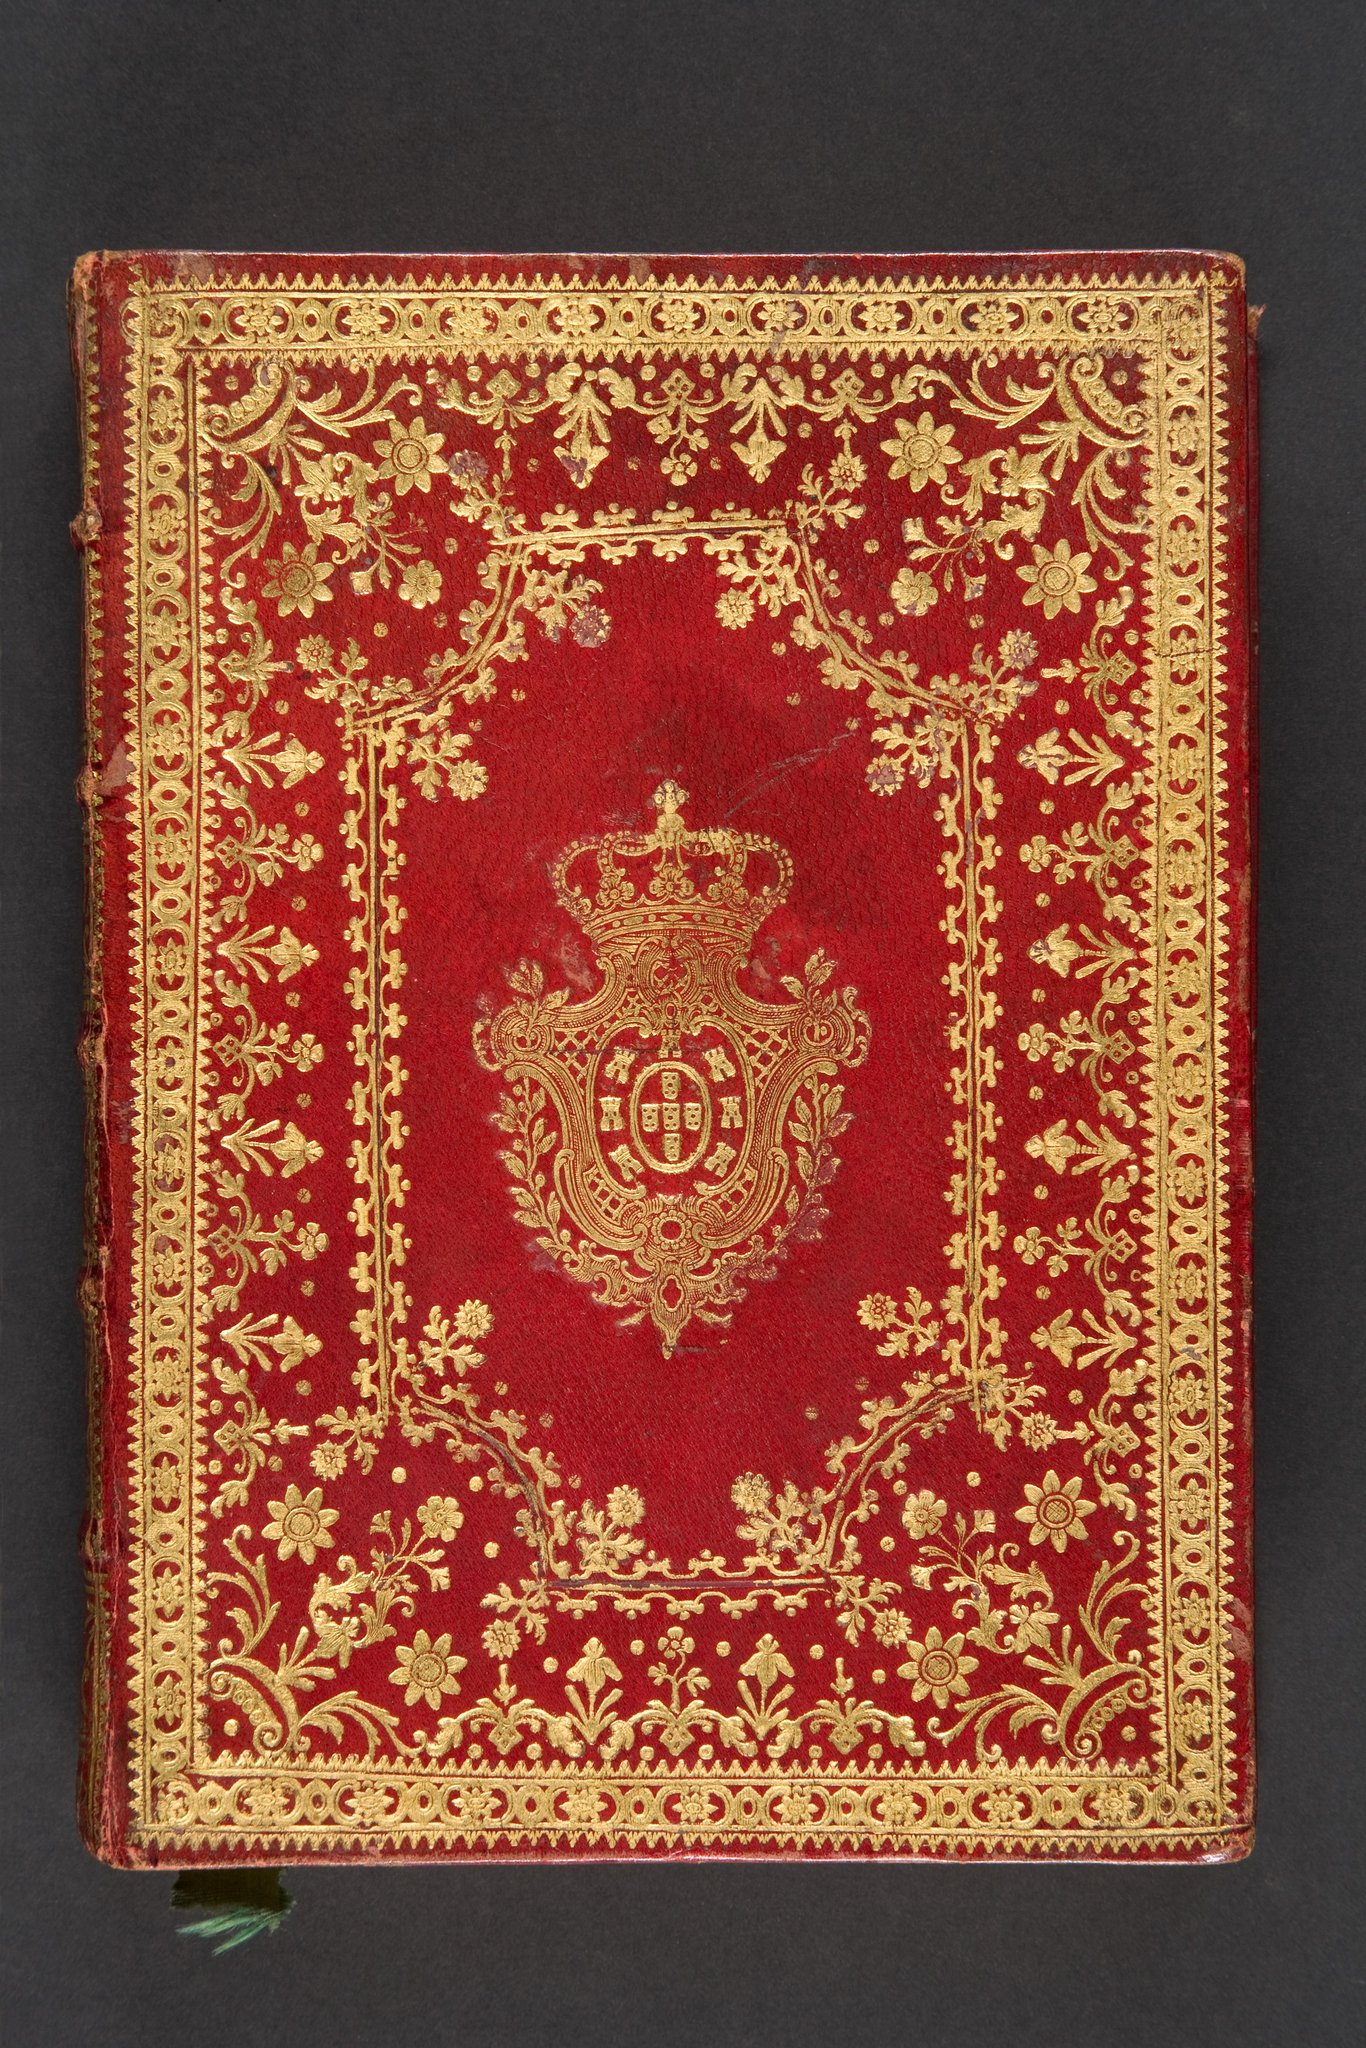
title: Dialogo sobre hua nova obra no Rio Tejo ...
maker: bento de moura portugal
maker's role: author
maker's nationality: portuguese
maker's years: 1702-1776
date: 1776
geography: portugal